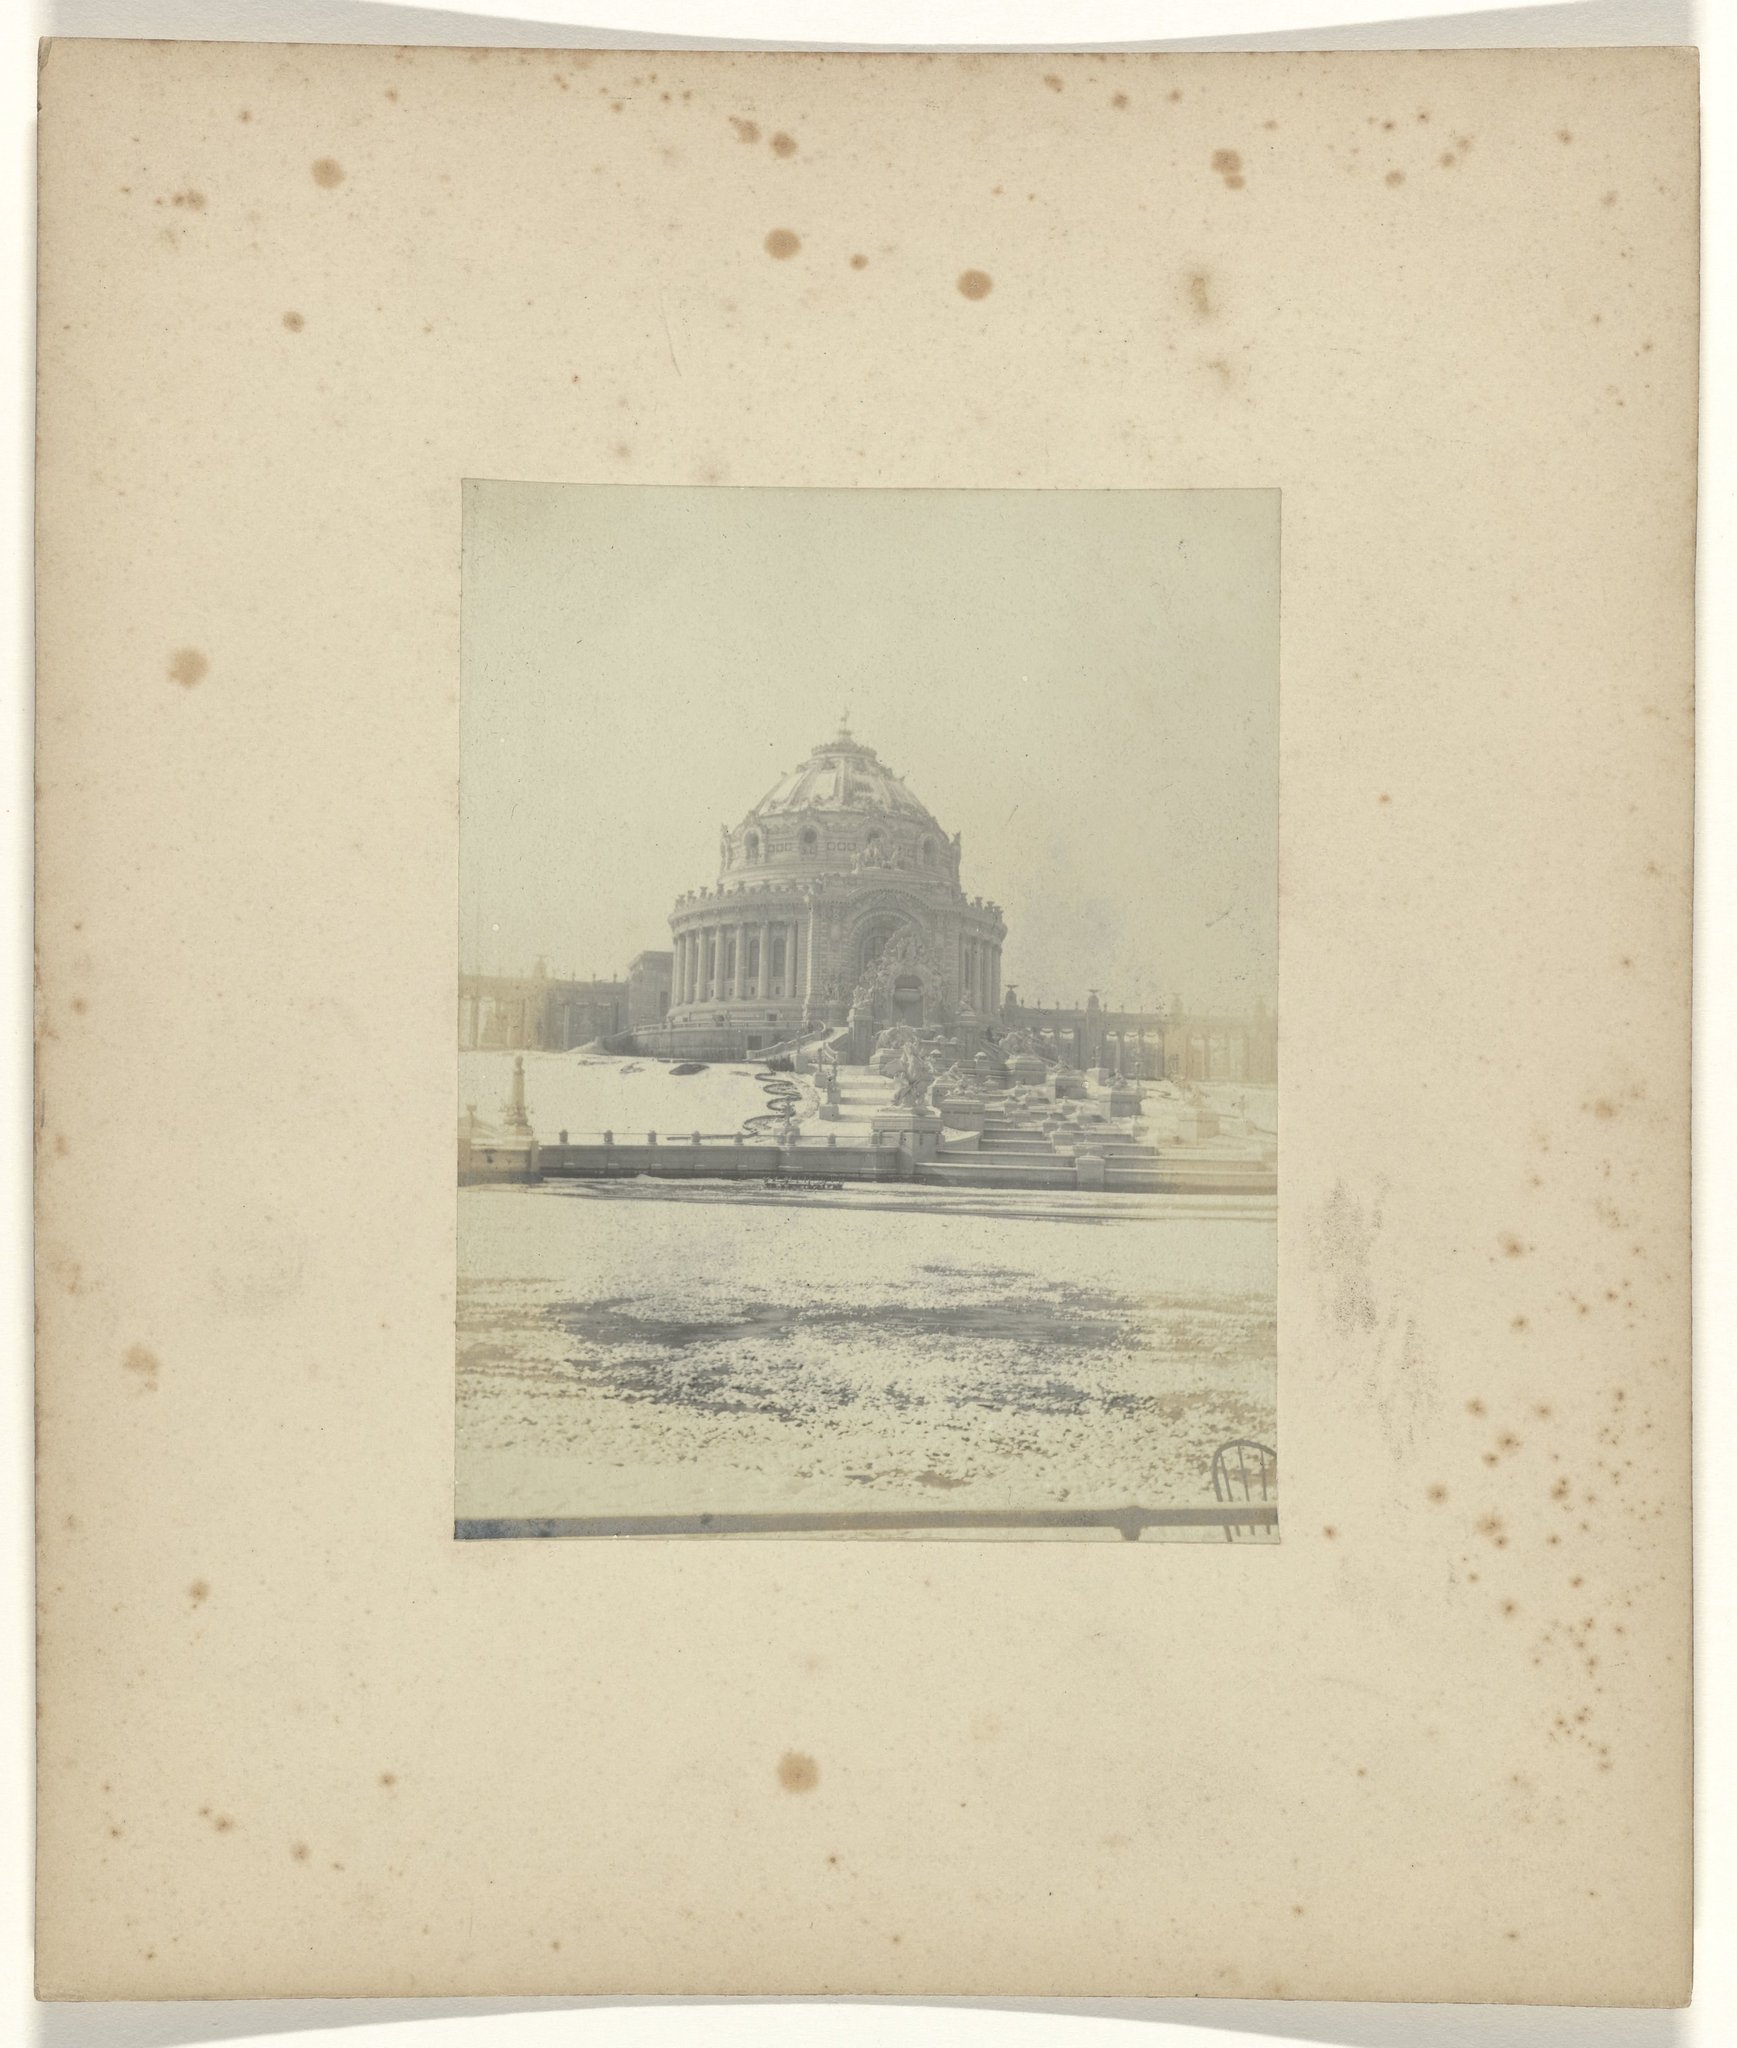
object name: photograph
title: Gezicht op de Festival Hall en het drooggelegde Grand Basin (of: Lagoon) op het terrein van de wereldtentoonstelling in St. Louis (Louisiana Purchase Exposition), 1904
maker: jan schüller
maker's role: draughtsman, painter, print maker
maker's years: 1871-1915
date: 1904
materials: cardboard, paper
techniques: gelatin silver print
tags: world fair, world exhibition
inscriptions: annotation: ‘The Lagoon zonder water er in’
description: Gezicht op de Festival Hall en het drooggelegde Grand Basin (of: Lagoon) op het terrein van de wereldtentoonstelling in St. Louis (Louisiana Purchase Exposition), 1904.